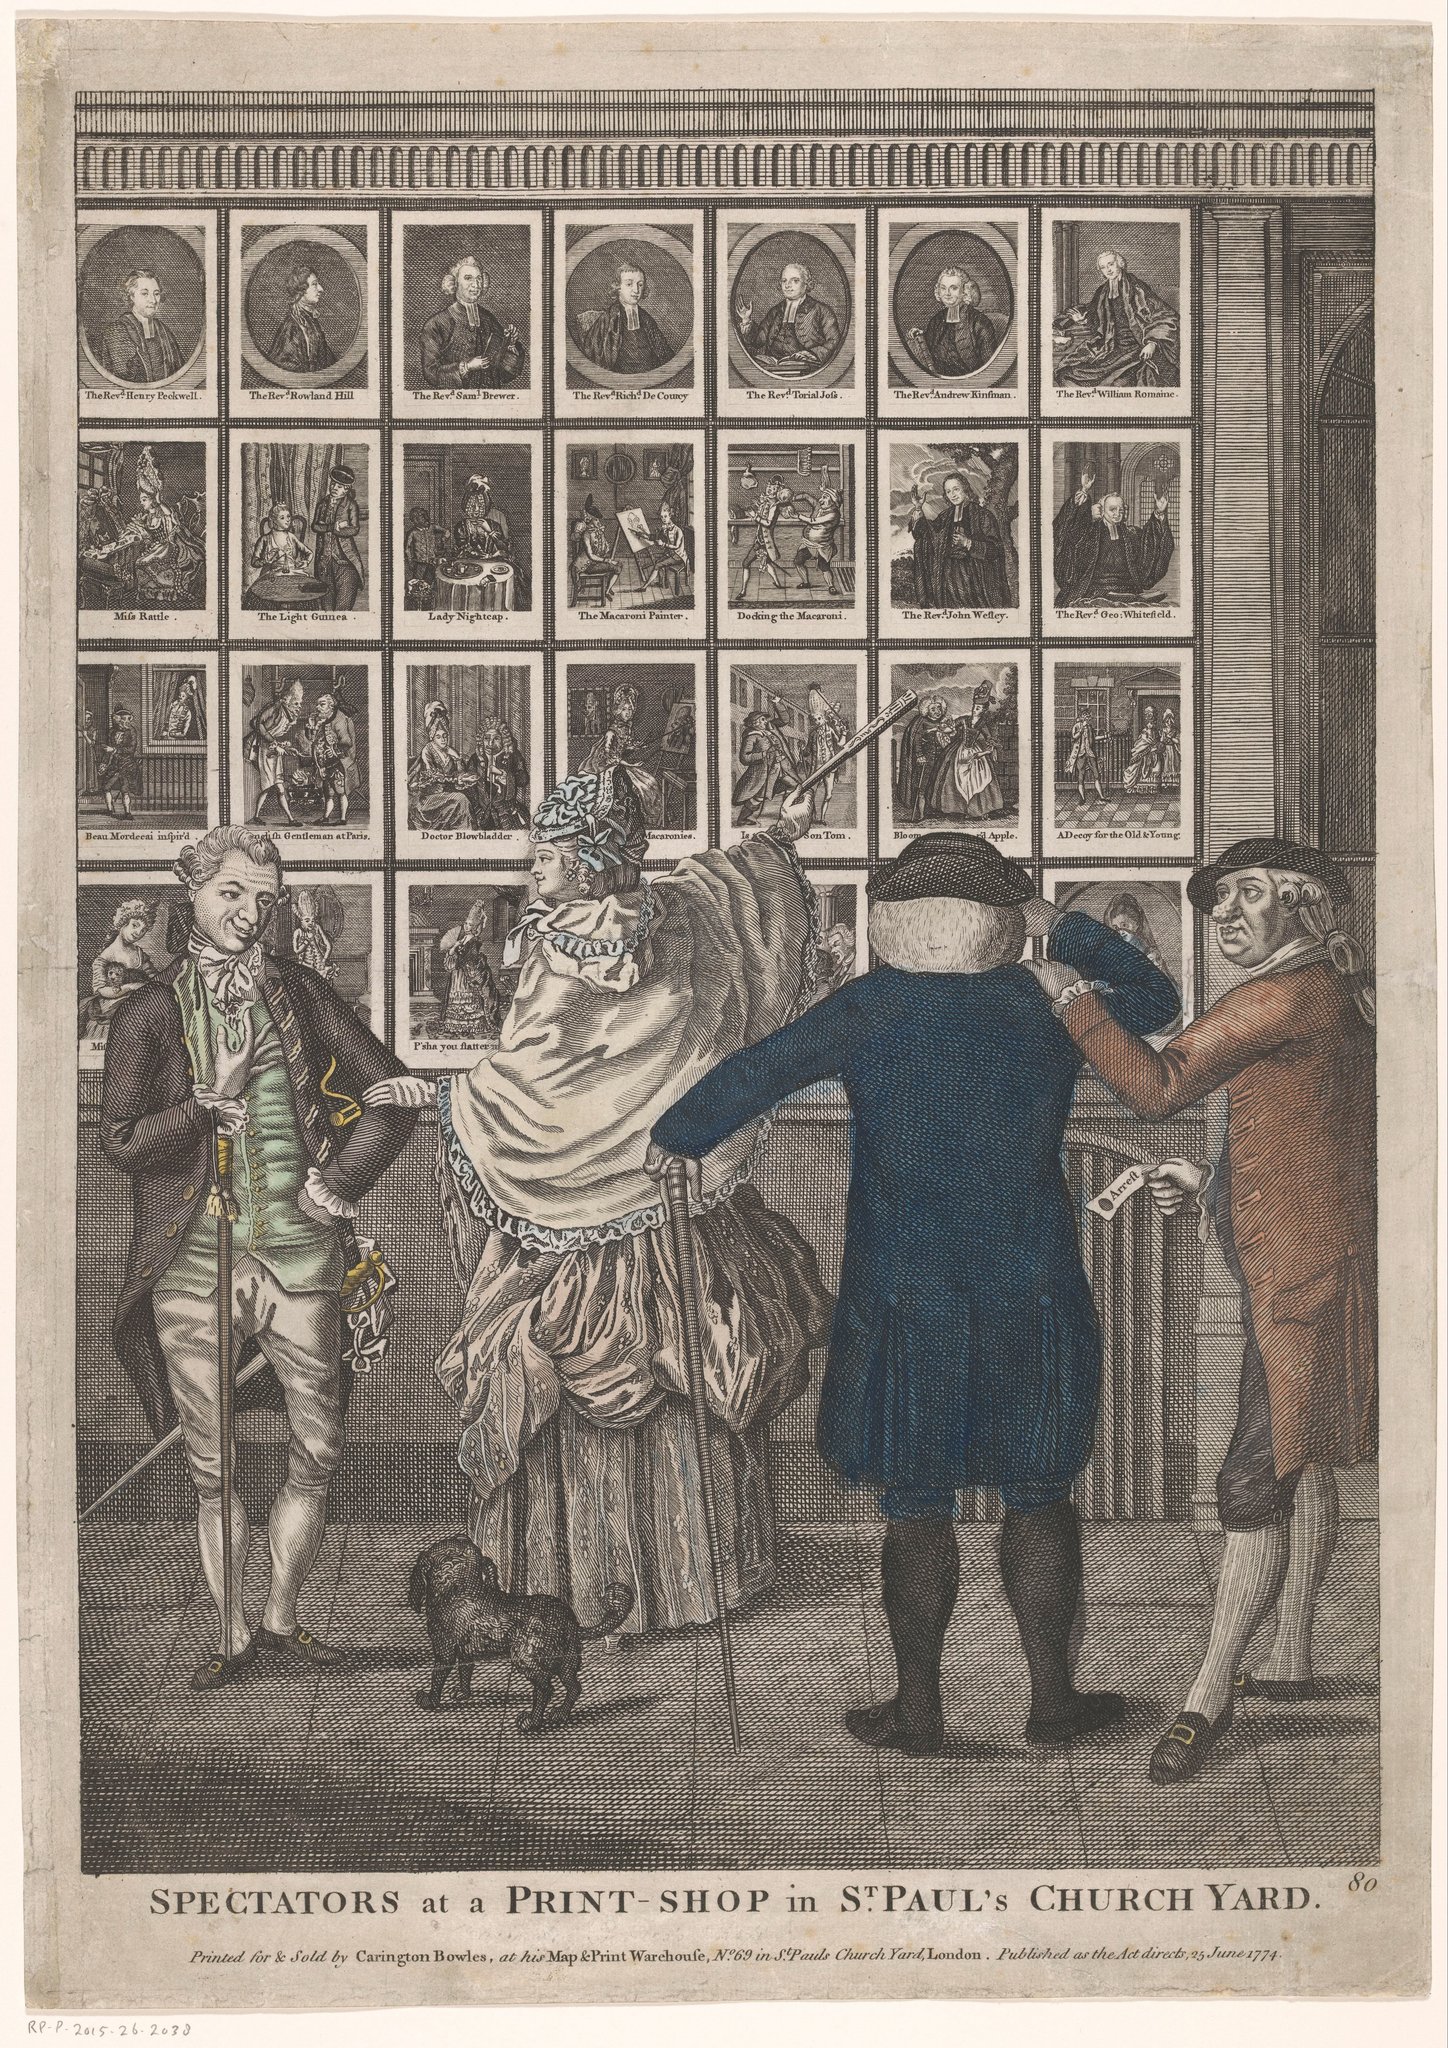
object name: print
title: Vier personen voor de etalage van prenthandel Carrington Bowles te Londen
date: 1774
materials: paper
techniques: engraving, etching, hand coloring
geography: london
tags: print, e.g.: engraving, etching, lithograph, art dealer (+ graphic arts), fan, fashion, political caricatures and satires, dog, shop-window, show-window, london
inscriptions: collector's mark: Lugt 4780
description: Links een man en een vrouw in modieuze kleding; tussen hen in een hondje. De vrouw wijst met een gesloten waaier naar de prenten in de etalage. Rechts staat een man met een stok. Een man met een arrestatiebevel legt zijn hand op zijn schouder. Rechtsonder genummerd: 80.